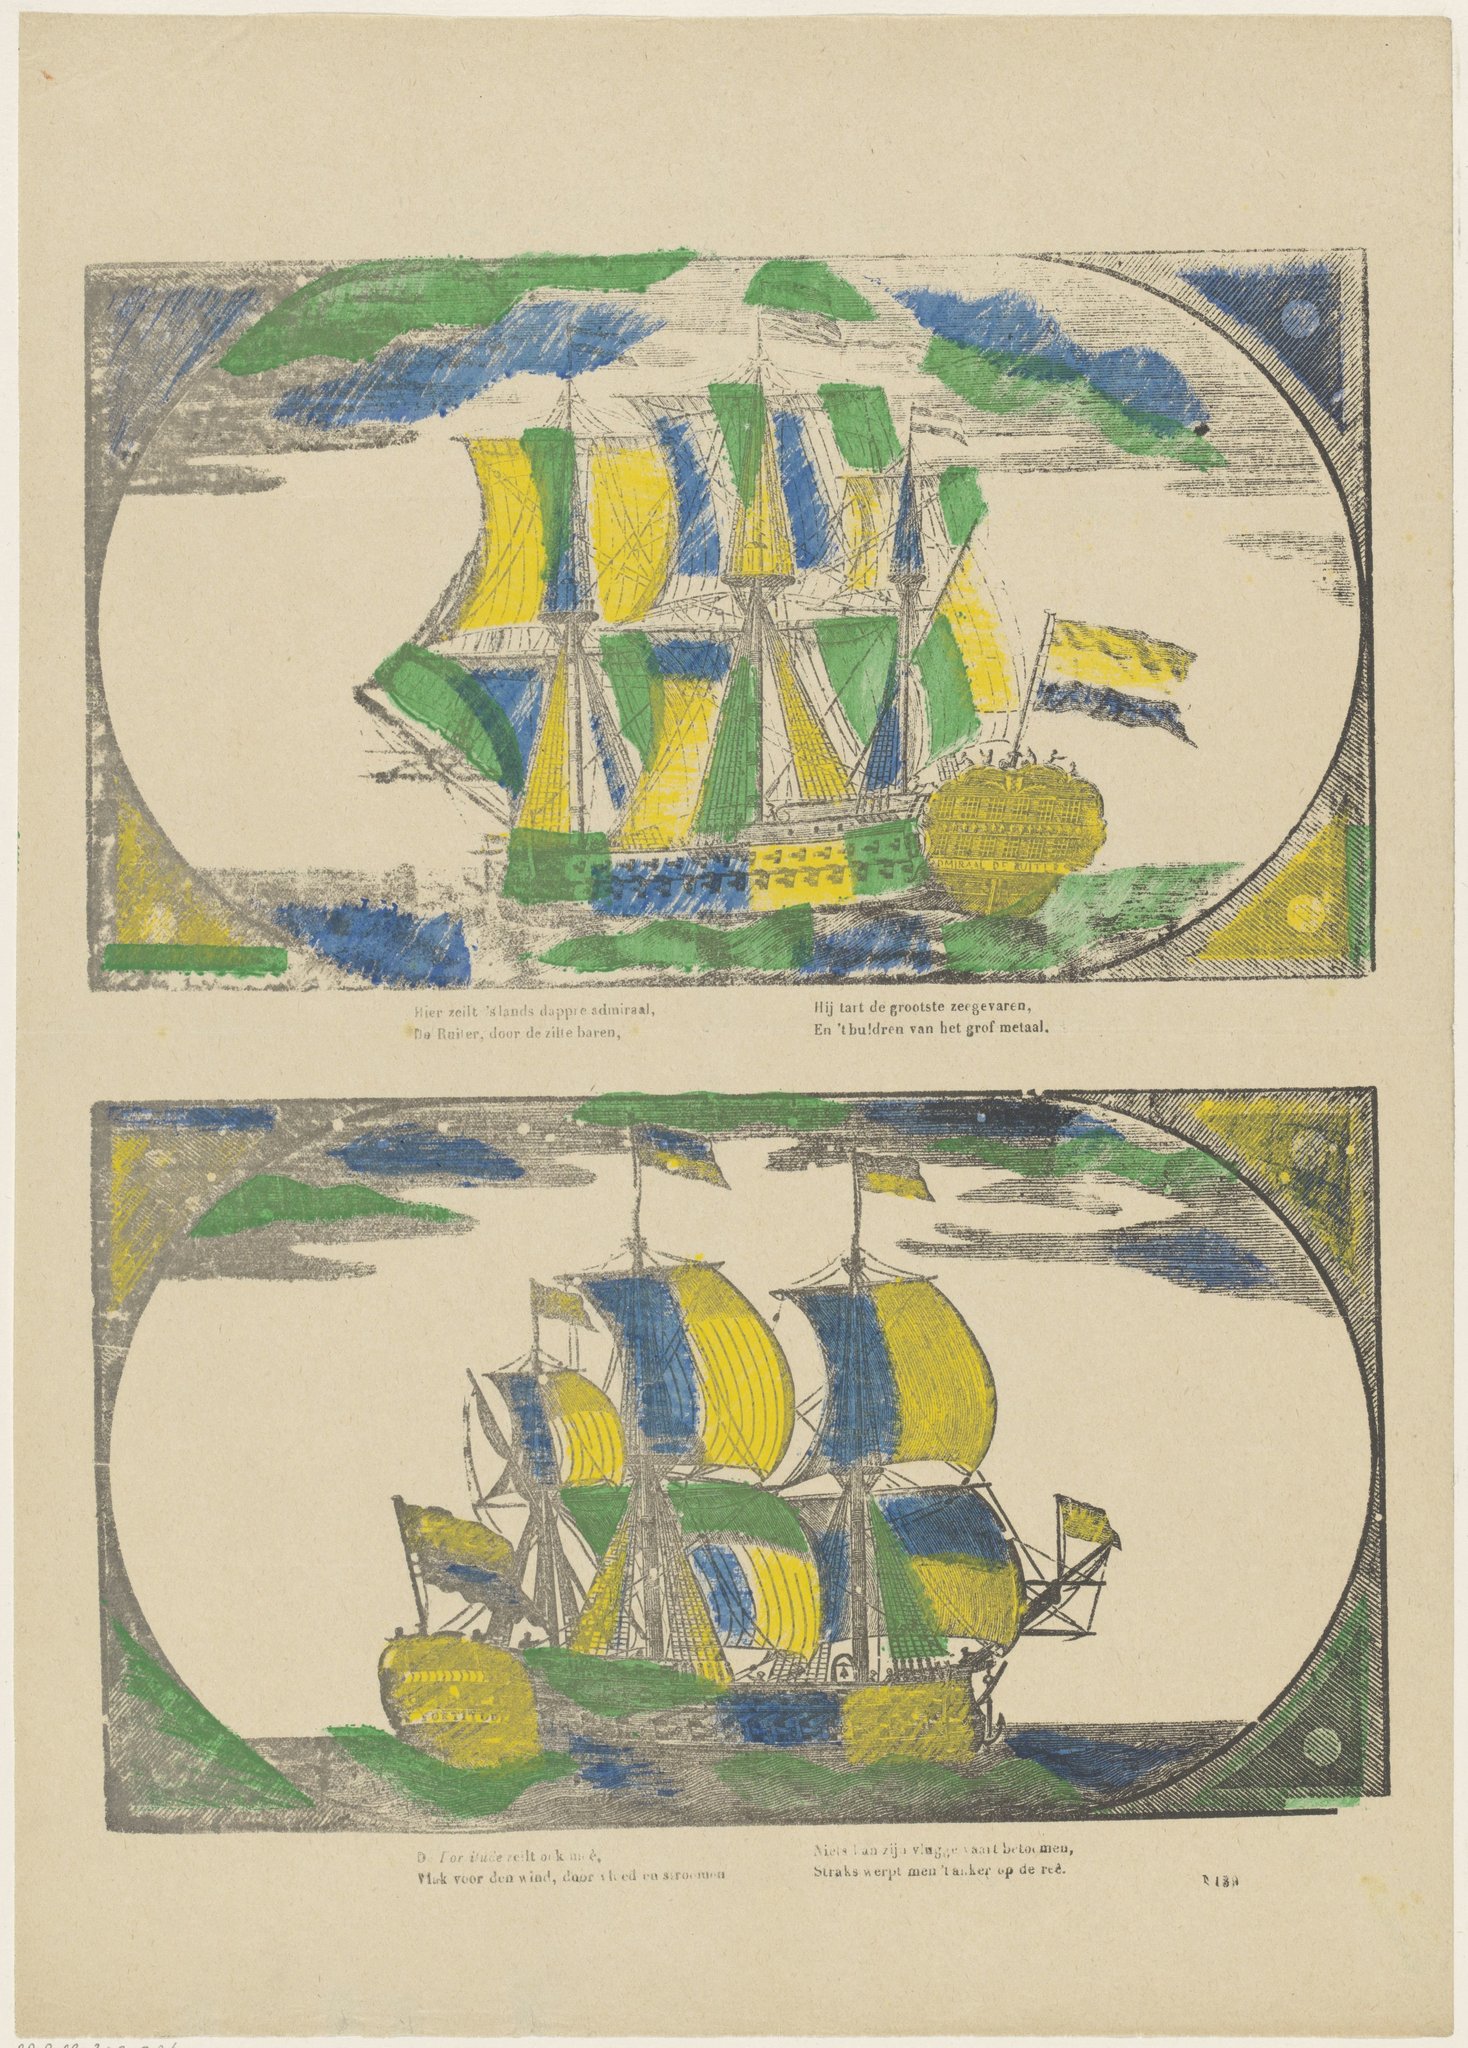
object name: popular print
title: Oorlogsschepen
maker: a. bouwens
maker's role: bloksnijder, houtsnijder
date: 1833-1900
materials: paper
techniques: colour, letterpress printing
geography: amsterdam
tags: military vehicles (+ sailing-ships), ships (in general)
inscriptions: collector's mark: Lugt 2760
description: Blad met 2 voorstellingen van oorlogsschepen. Onder elke afbeelding een vierregelig vers in twee kolommen. Genummerd rechtsonder: N 139.